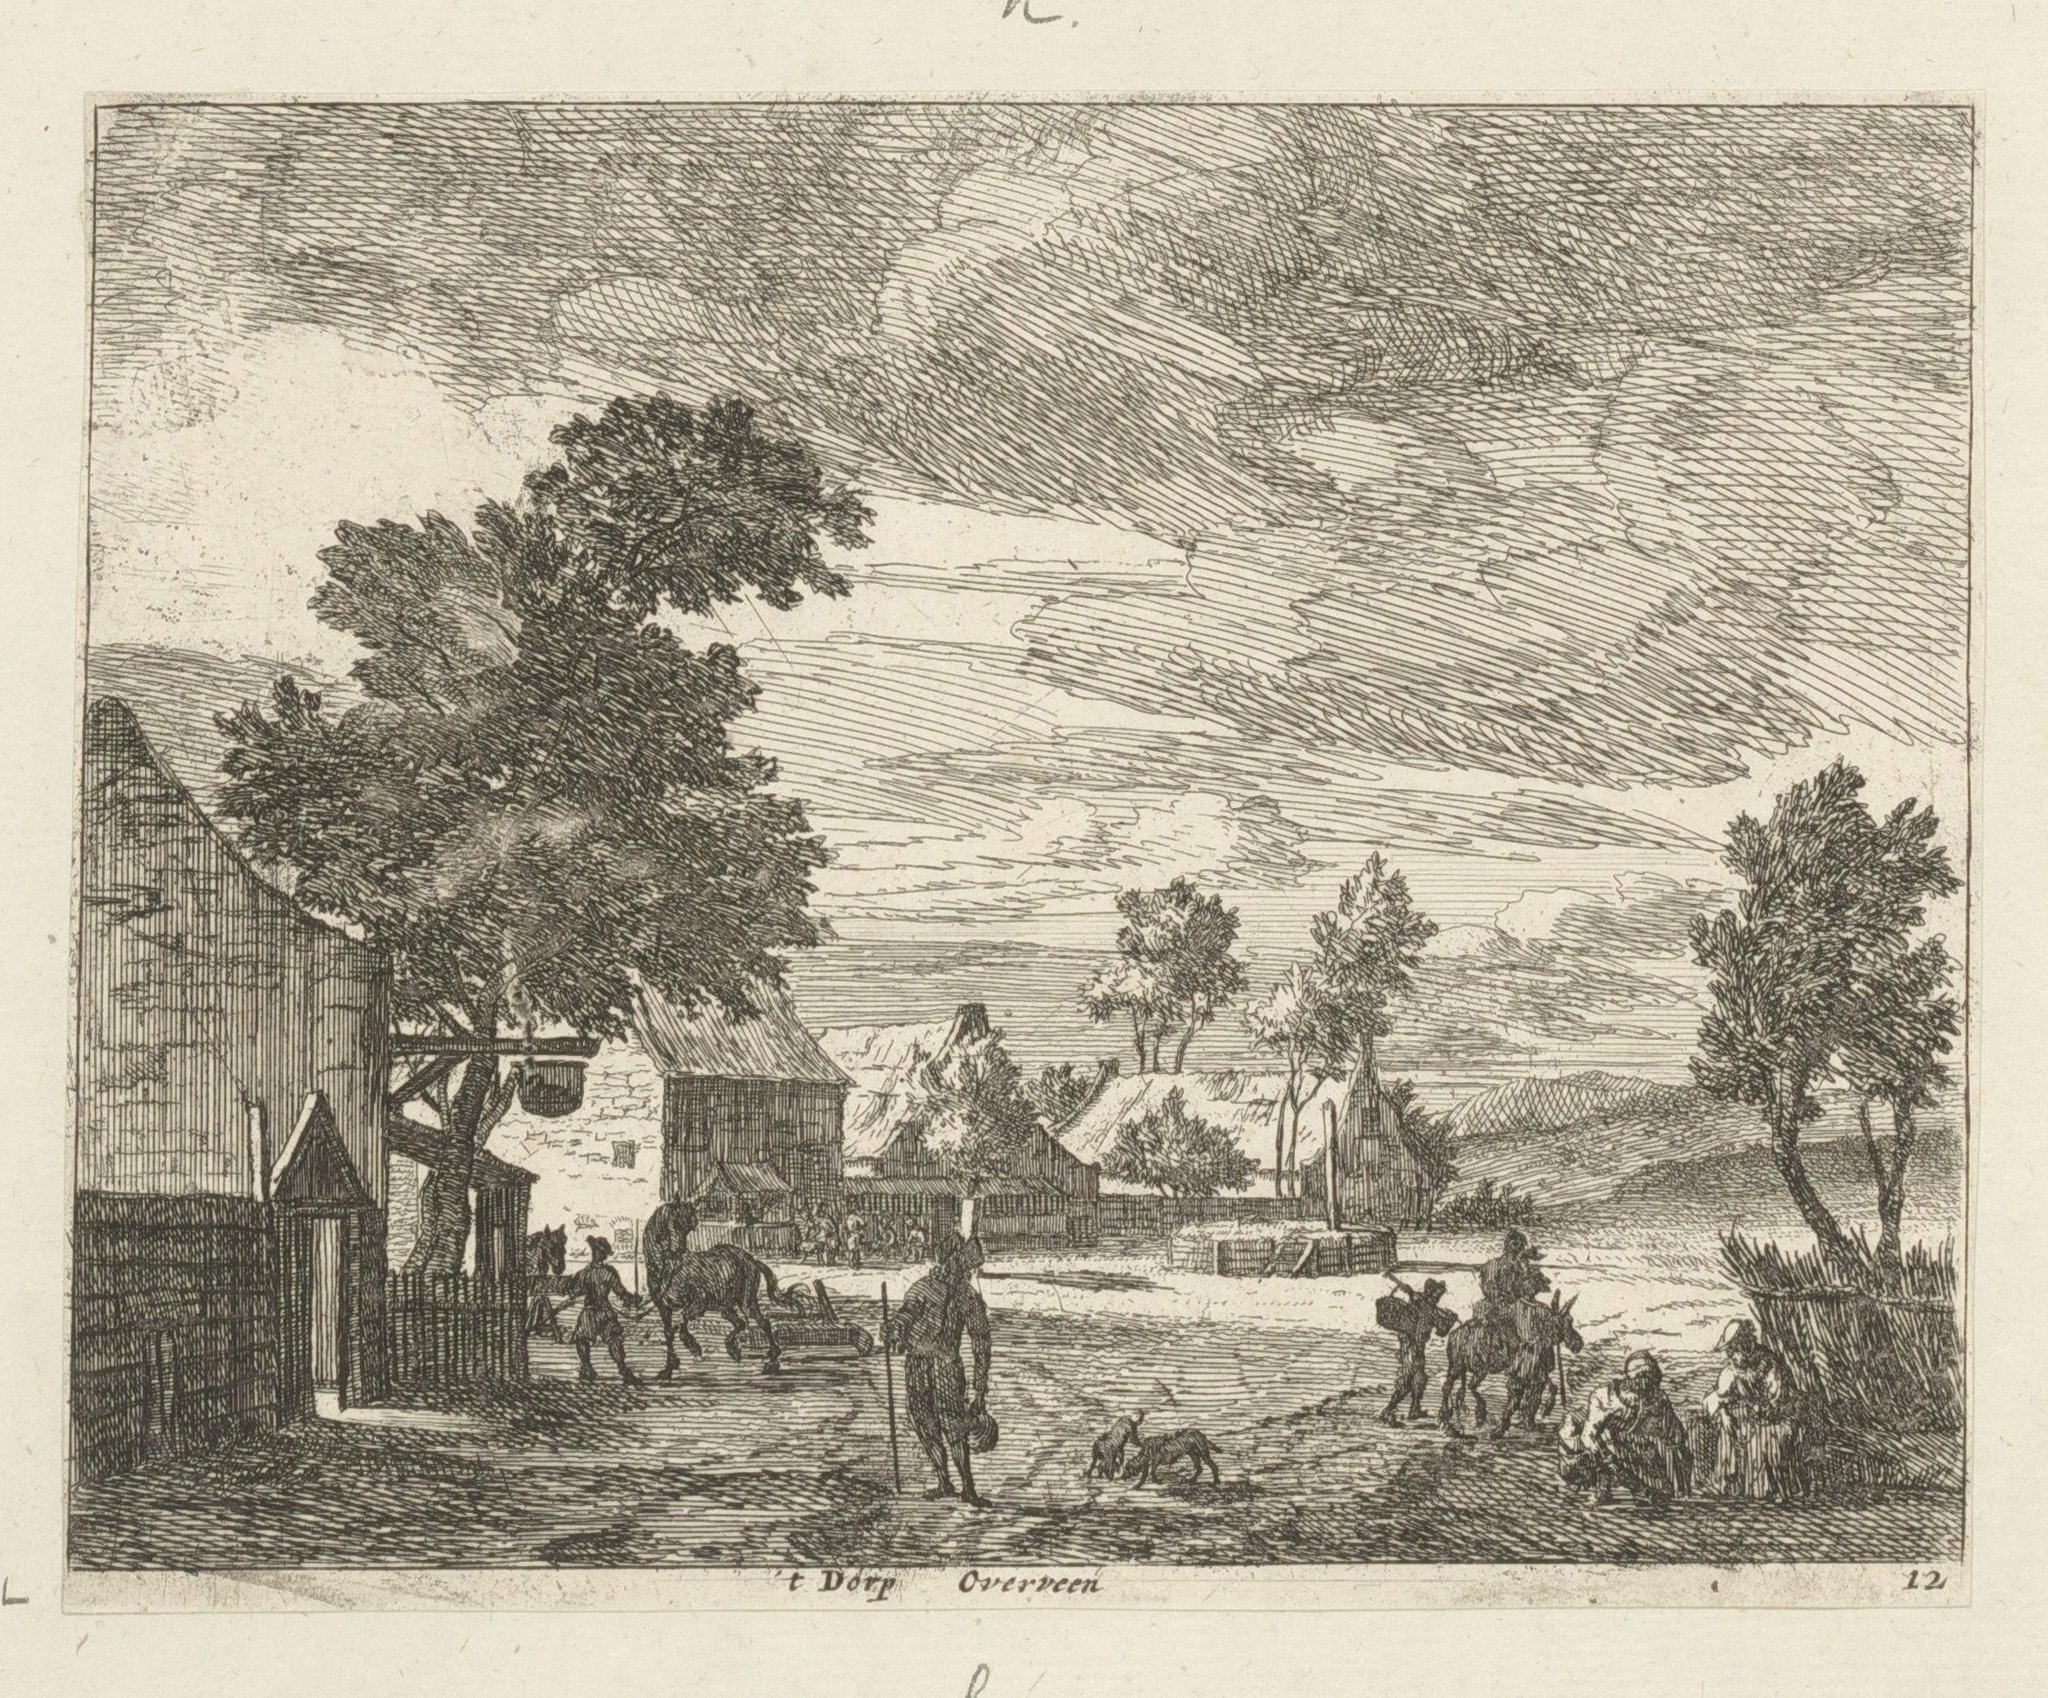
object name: print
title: 't Dorp Overveen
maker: jan vincentsz. van der vinne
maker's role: draughtsman, print maker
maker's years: 1663-1721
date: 1688-1690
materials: paper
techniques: engraving, etching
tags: inn, coffee-house, public house, etc., landscapes (+ landscape with figures, staffage), village square, place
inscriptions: stamp, stamp, collector's mark: Lugt 1641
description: Huizen en een herberg aan een weg te Overveen. Op de voorgrond verschillende figuren en dieren. Rechtsonder genummerd: 12. Onderwerpsrubrieken binnen de Atlas Zeden en Gewoonten: Handel, nijverheid en verkeer, Buitenleven.